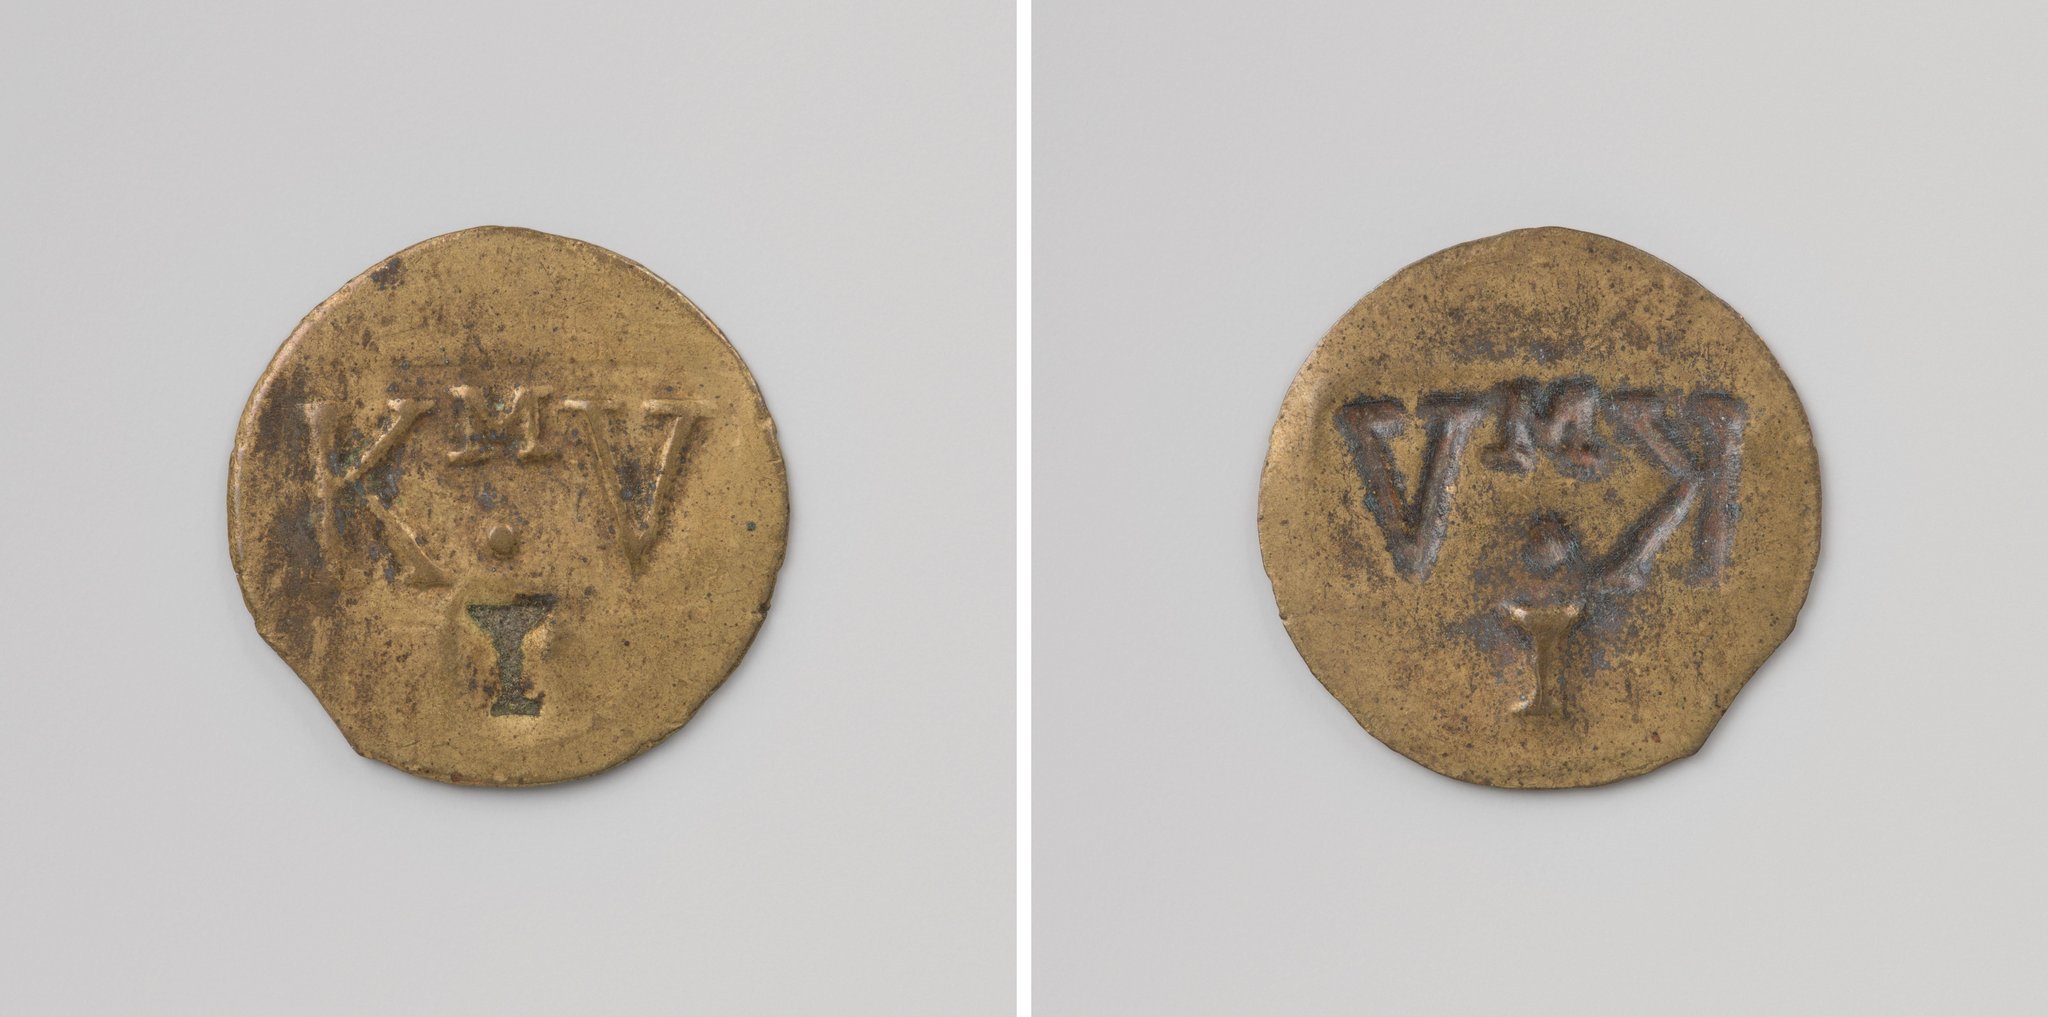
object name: cent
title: Kolonie Veenhuizen, huismunt geslagen op last van de Maatschappij van Weldadigheid ter waarde van 1 cent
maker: Anonymous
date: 1818-1859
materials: brass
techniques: striking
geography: netherlands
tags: maatschappij van weldadigheid, veenhuizen